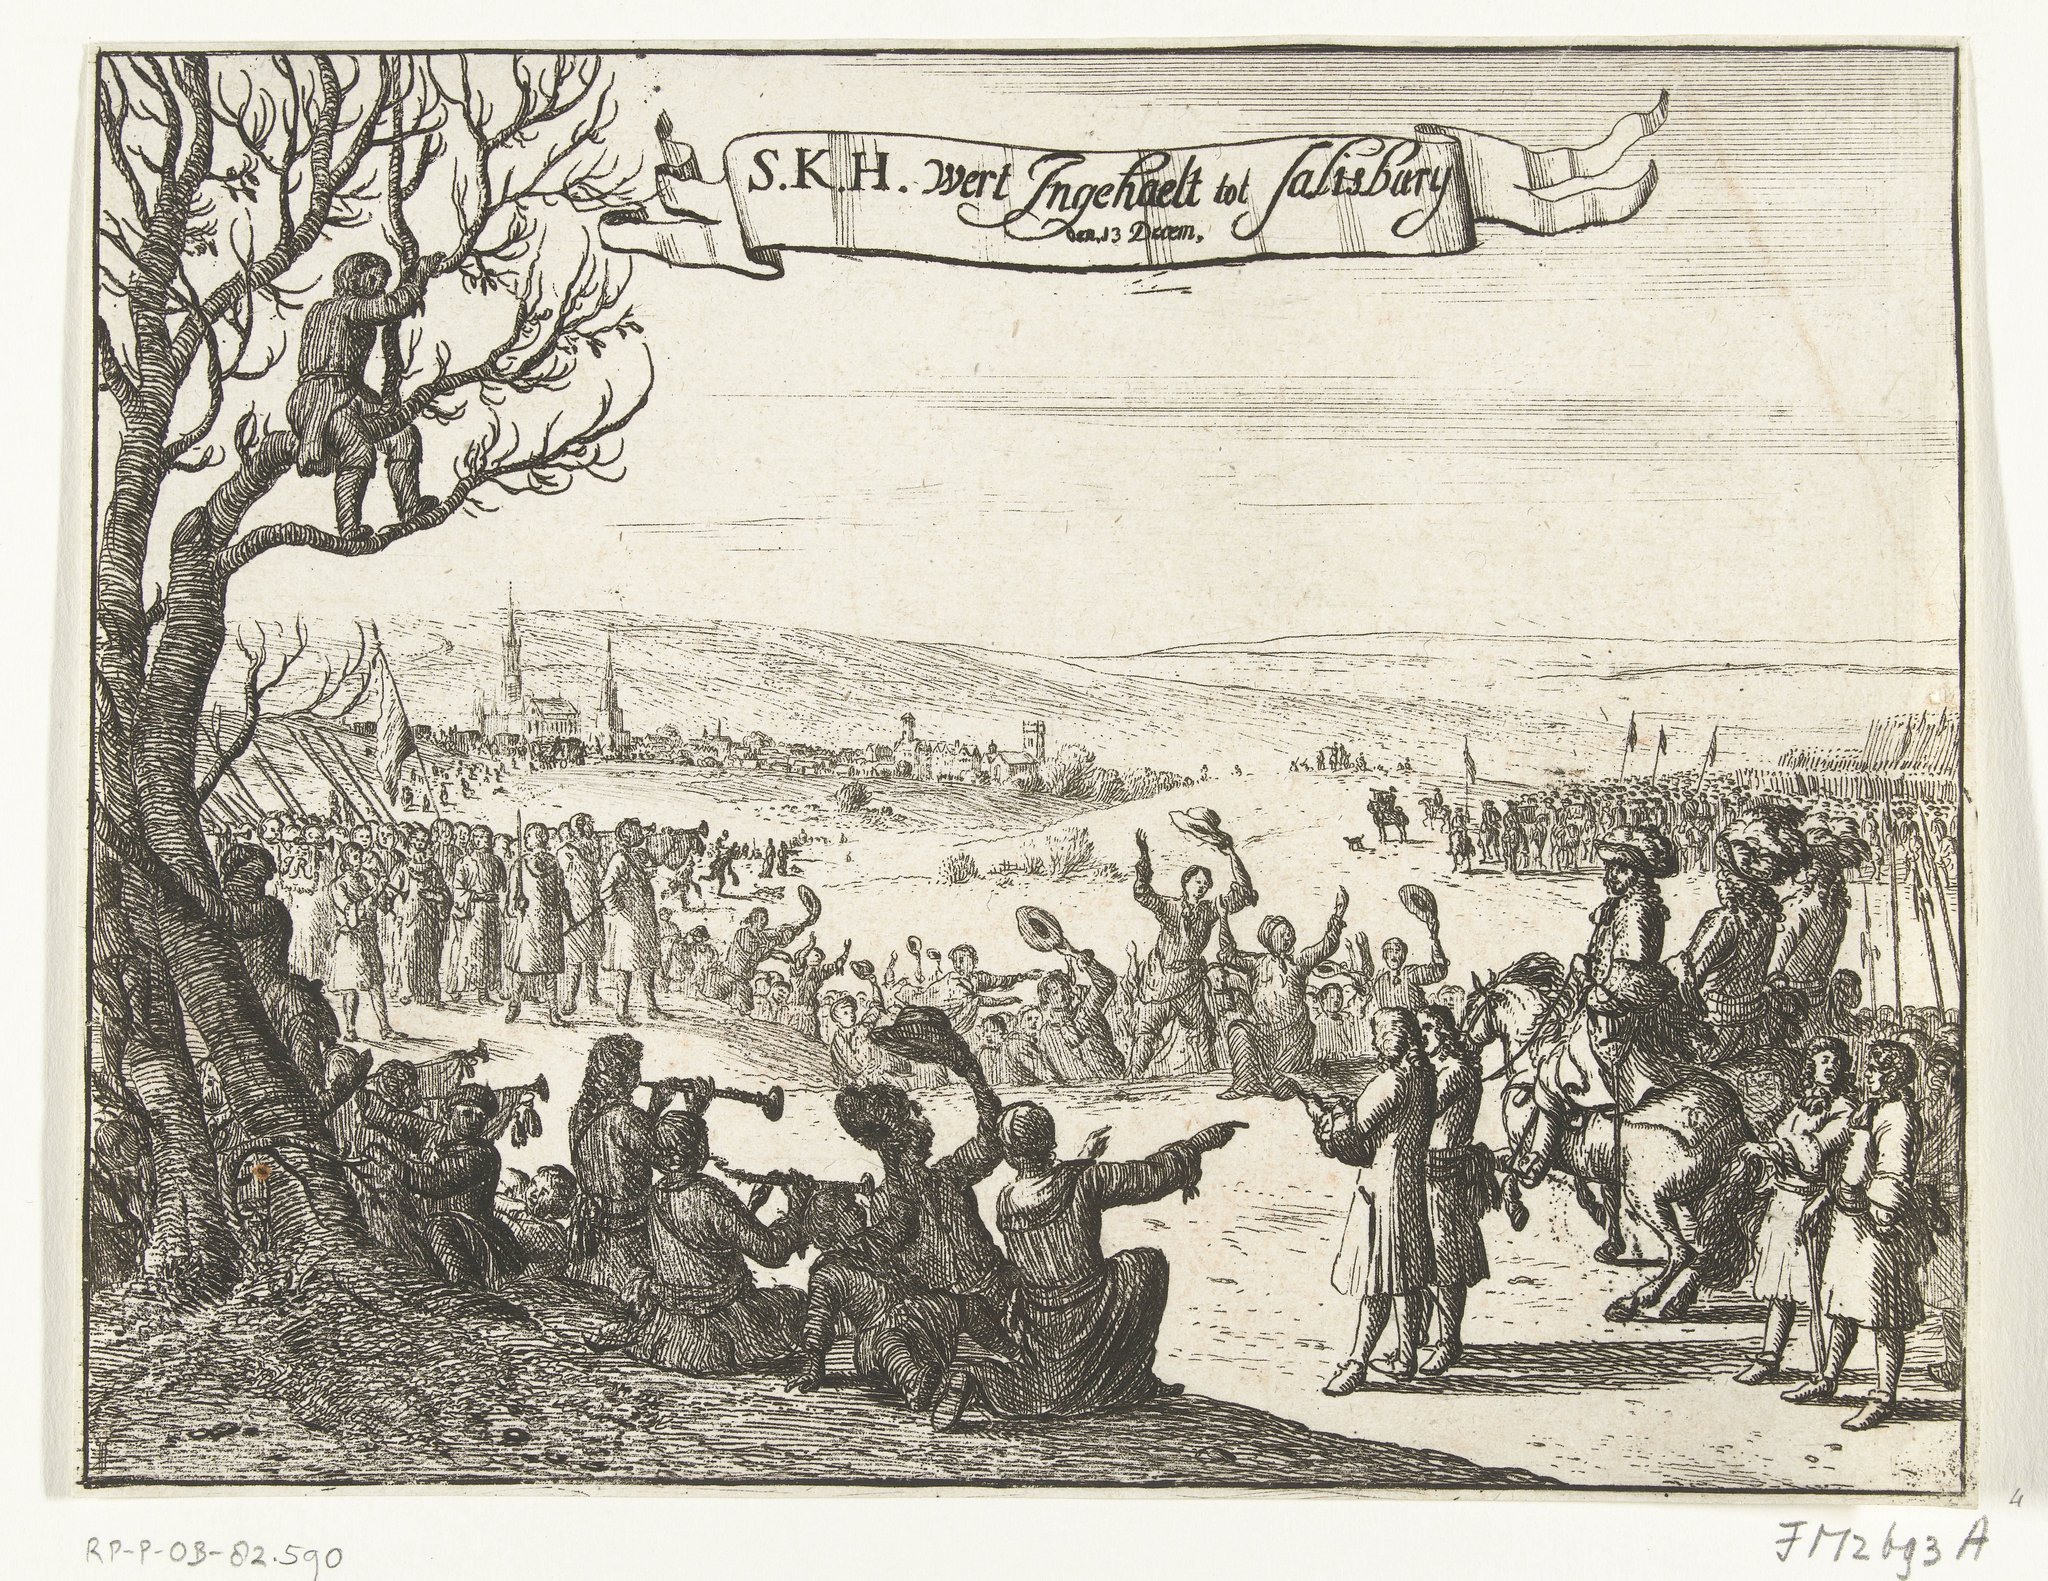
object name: print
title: S.K.H. wert Ingehaelt tot Salisburg den 13 Decem.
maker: Anonymous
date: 1688-1689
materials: paper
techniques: etching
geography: northern netherlands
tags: the hague, william iii (prince of orange and king of england, scotland, and ireland), being welcomed ~ travelling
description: Prins Willem III en zijn troepen worden verwelkomd door de inwoners van Salisbury, 13 december 1688.